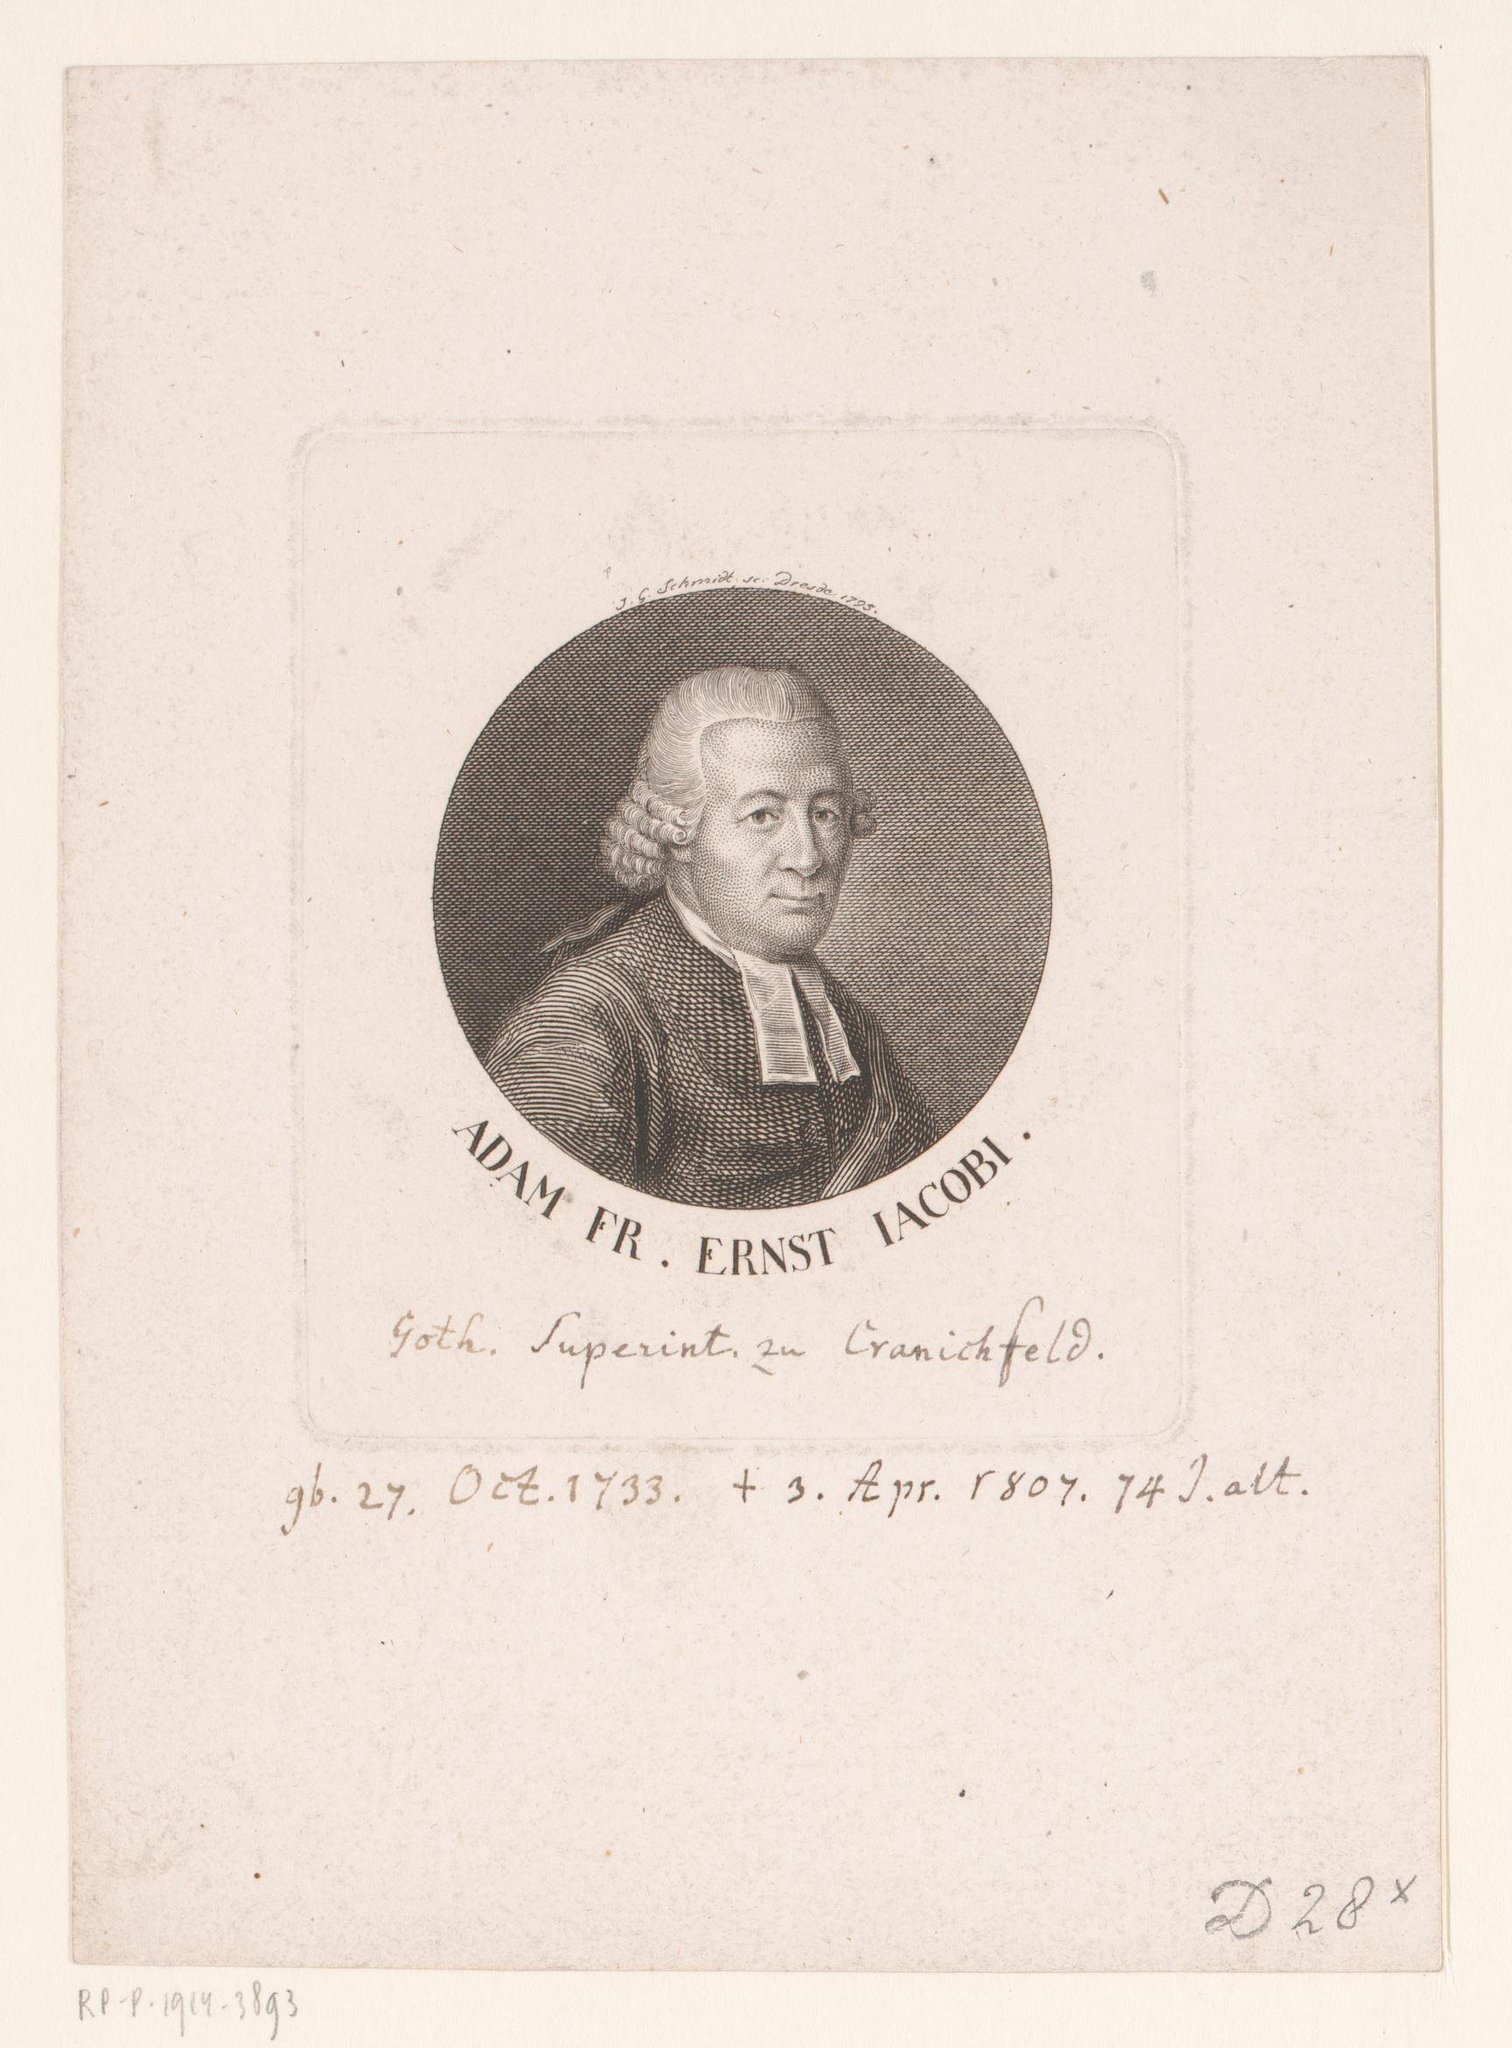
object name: print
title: Portret van Adam Friedrich Ernst Jacobi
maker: johann gottfried schmidt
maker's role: print maker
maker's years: 1764-1803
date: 1795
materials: paper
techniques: engraving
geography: dresden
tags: priest, historical persons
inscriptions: collector's mark: Lugt 2228